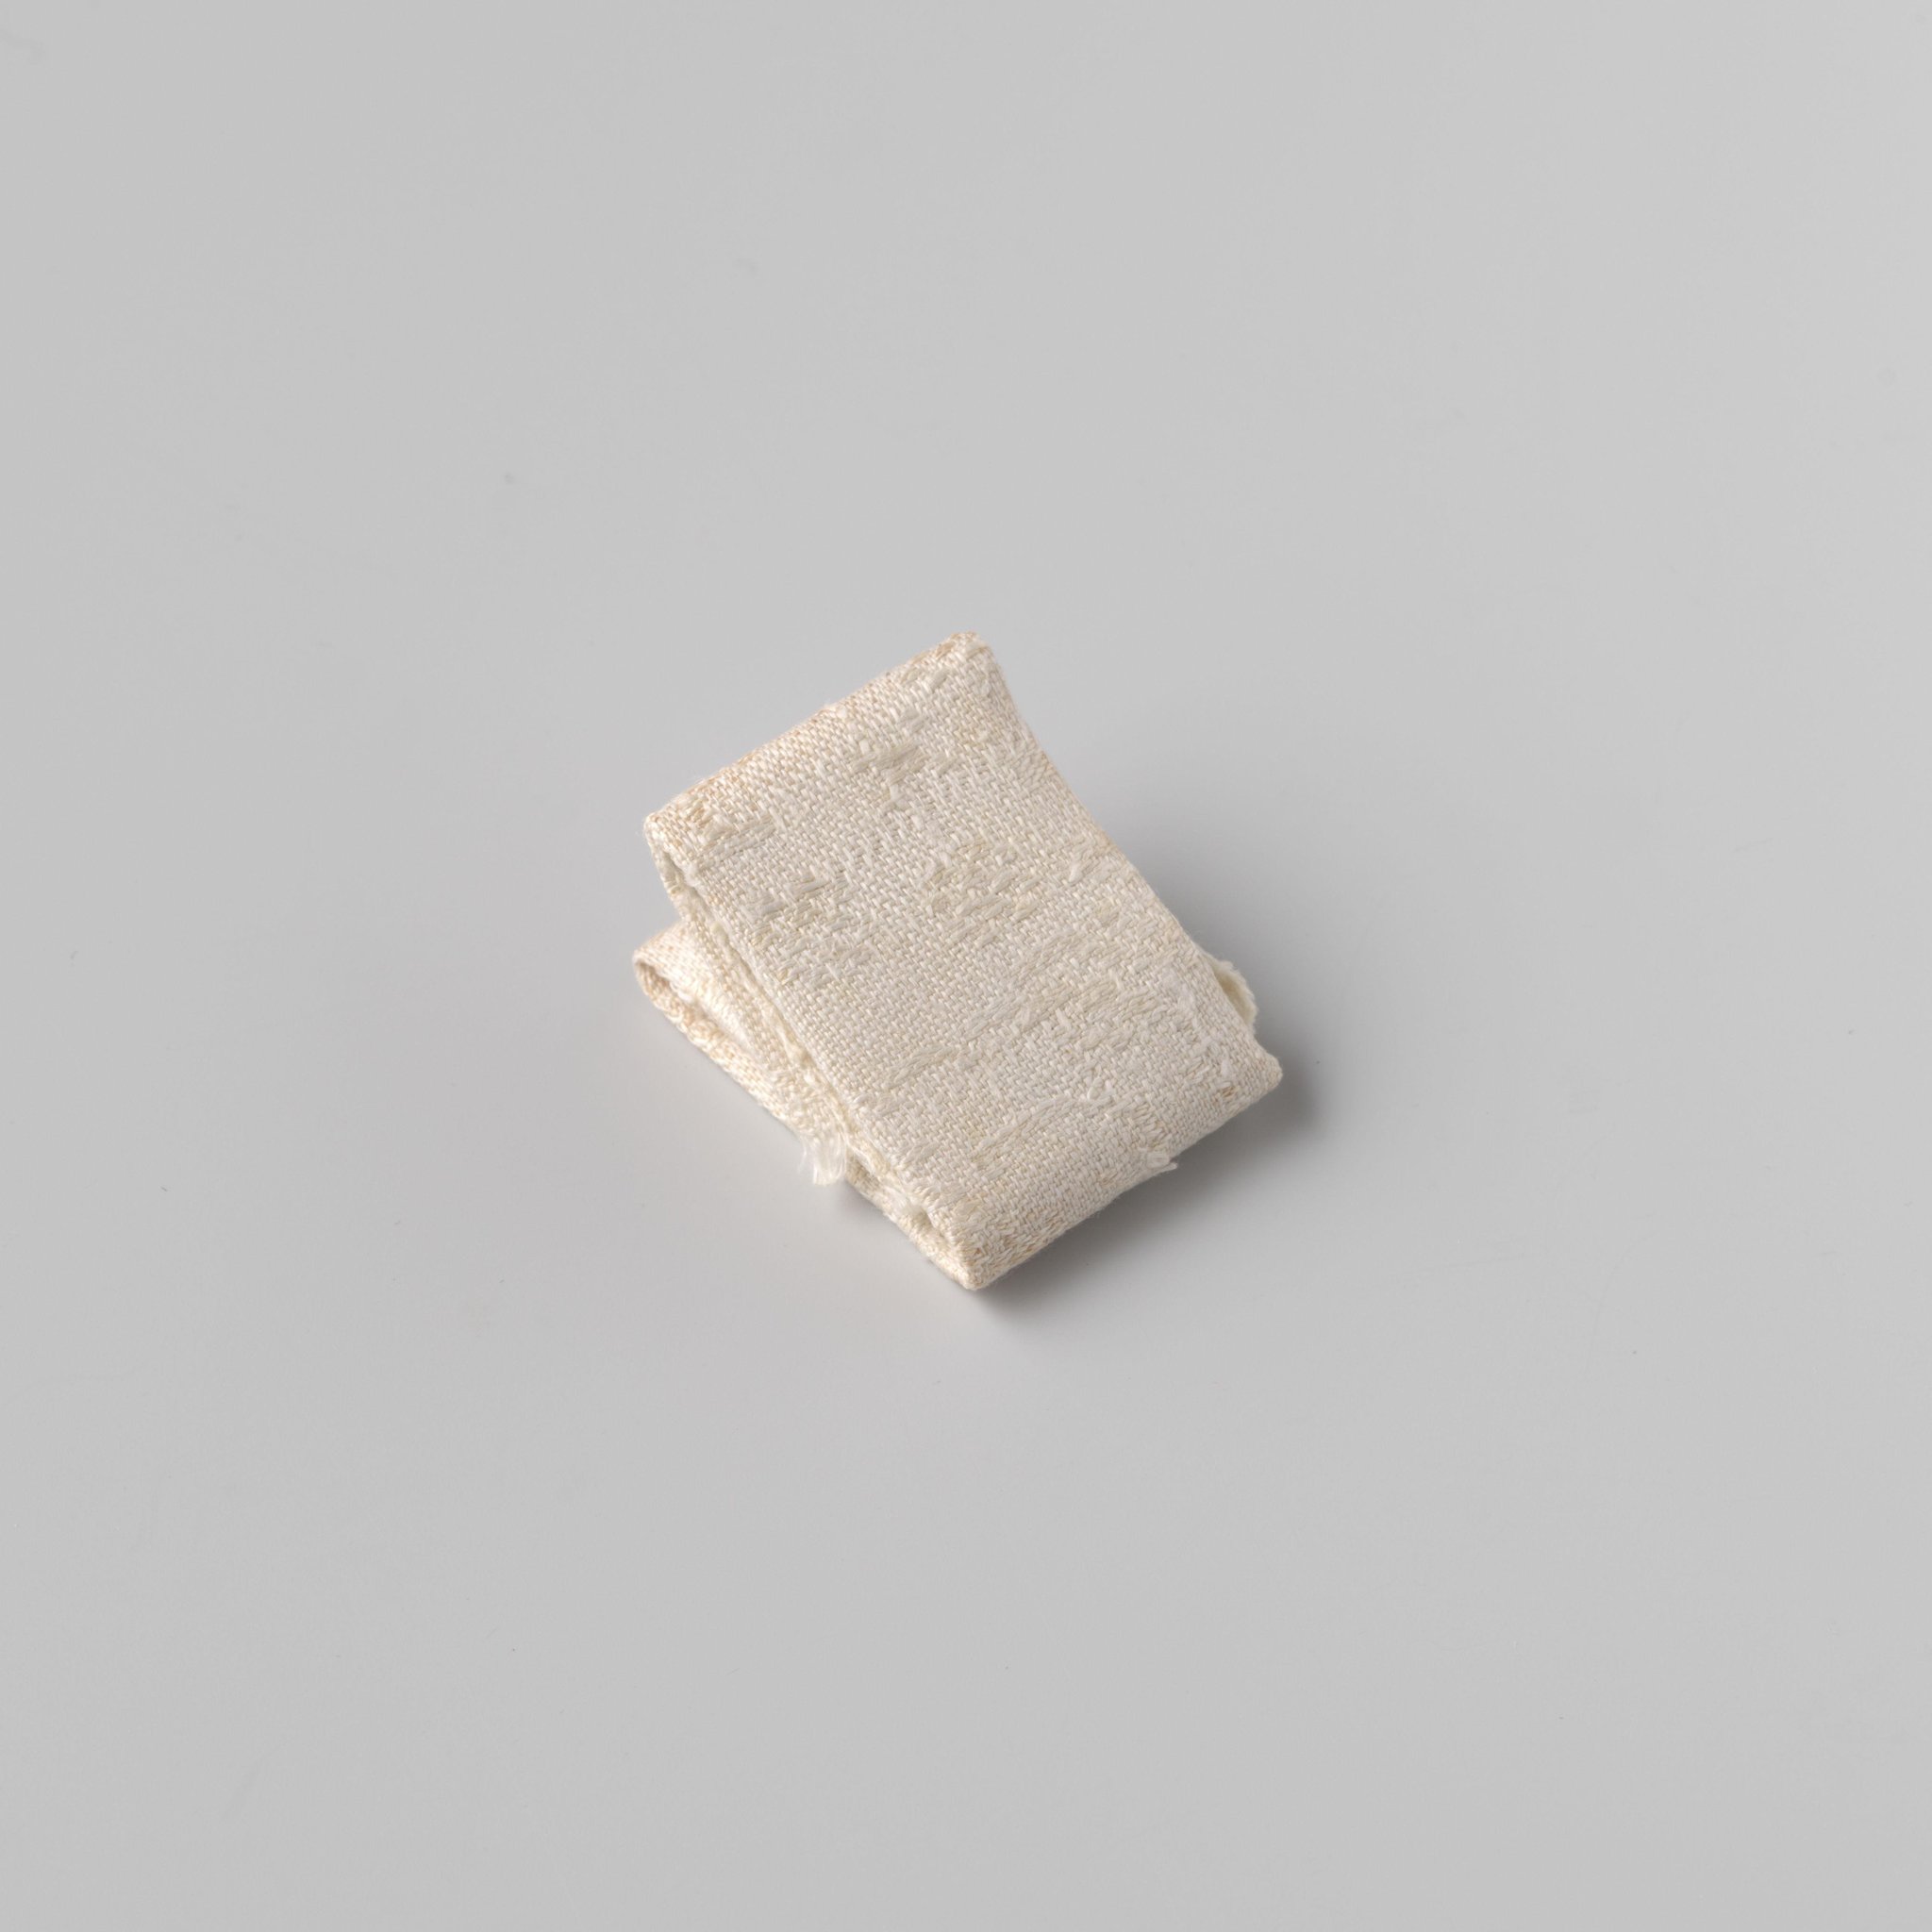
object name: napkin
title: Linnen servet van damastweefsel, met centraal ingeweven monogram BO, waar boven en onder een vogel met opgeheven poot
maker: Anonymous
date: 1690-1710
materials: linen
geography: amsterdam